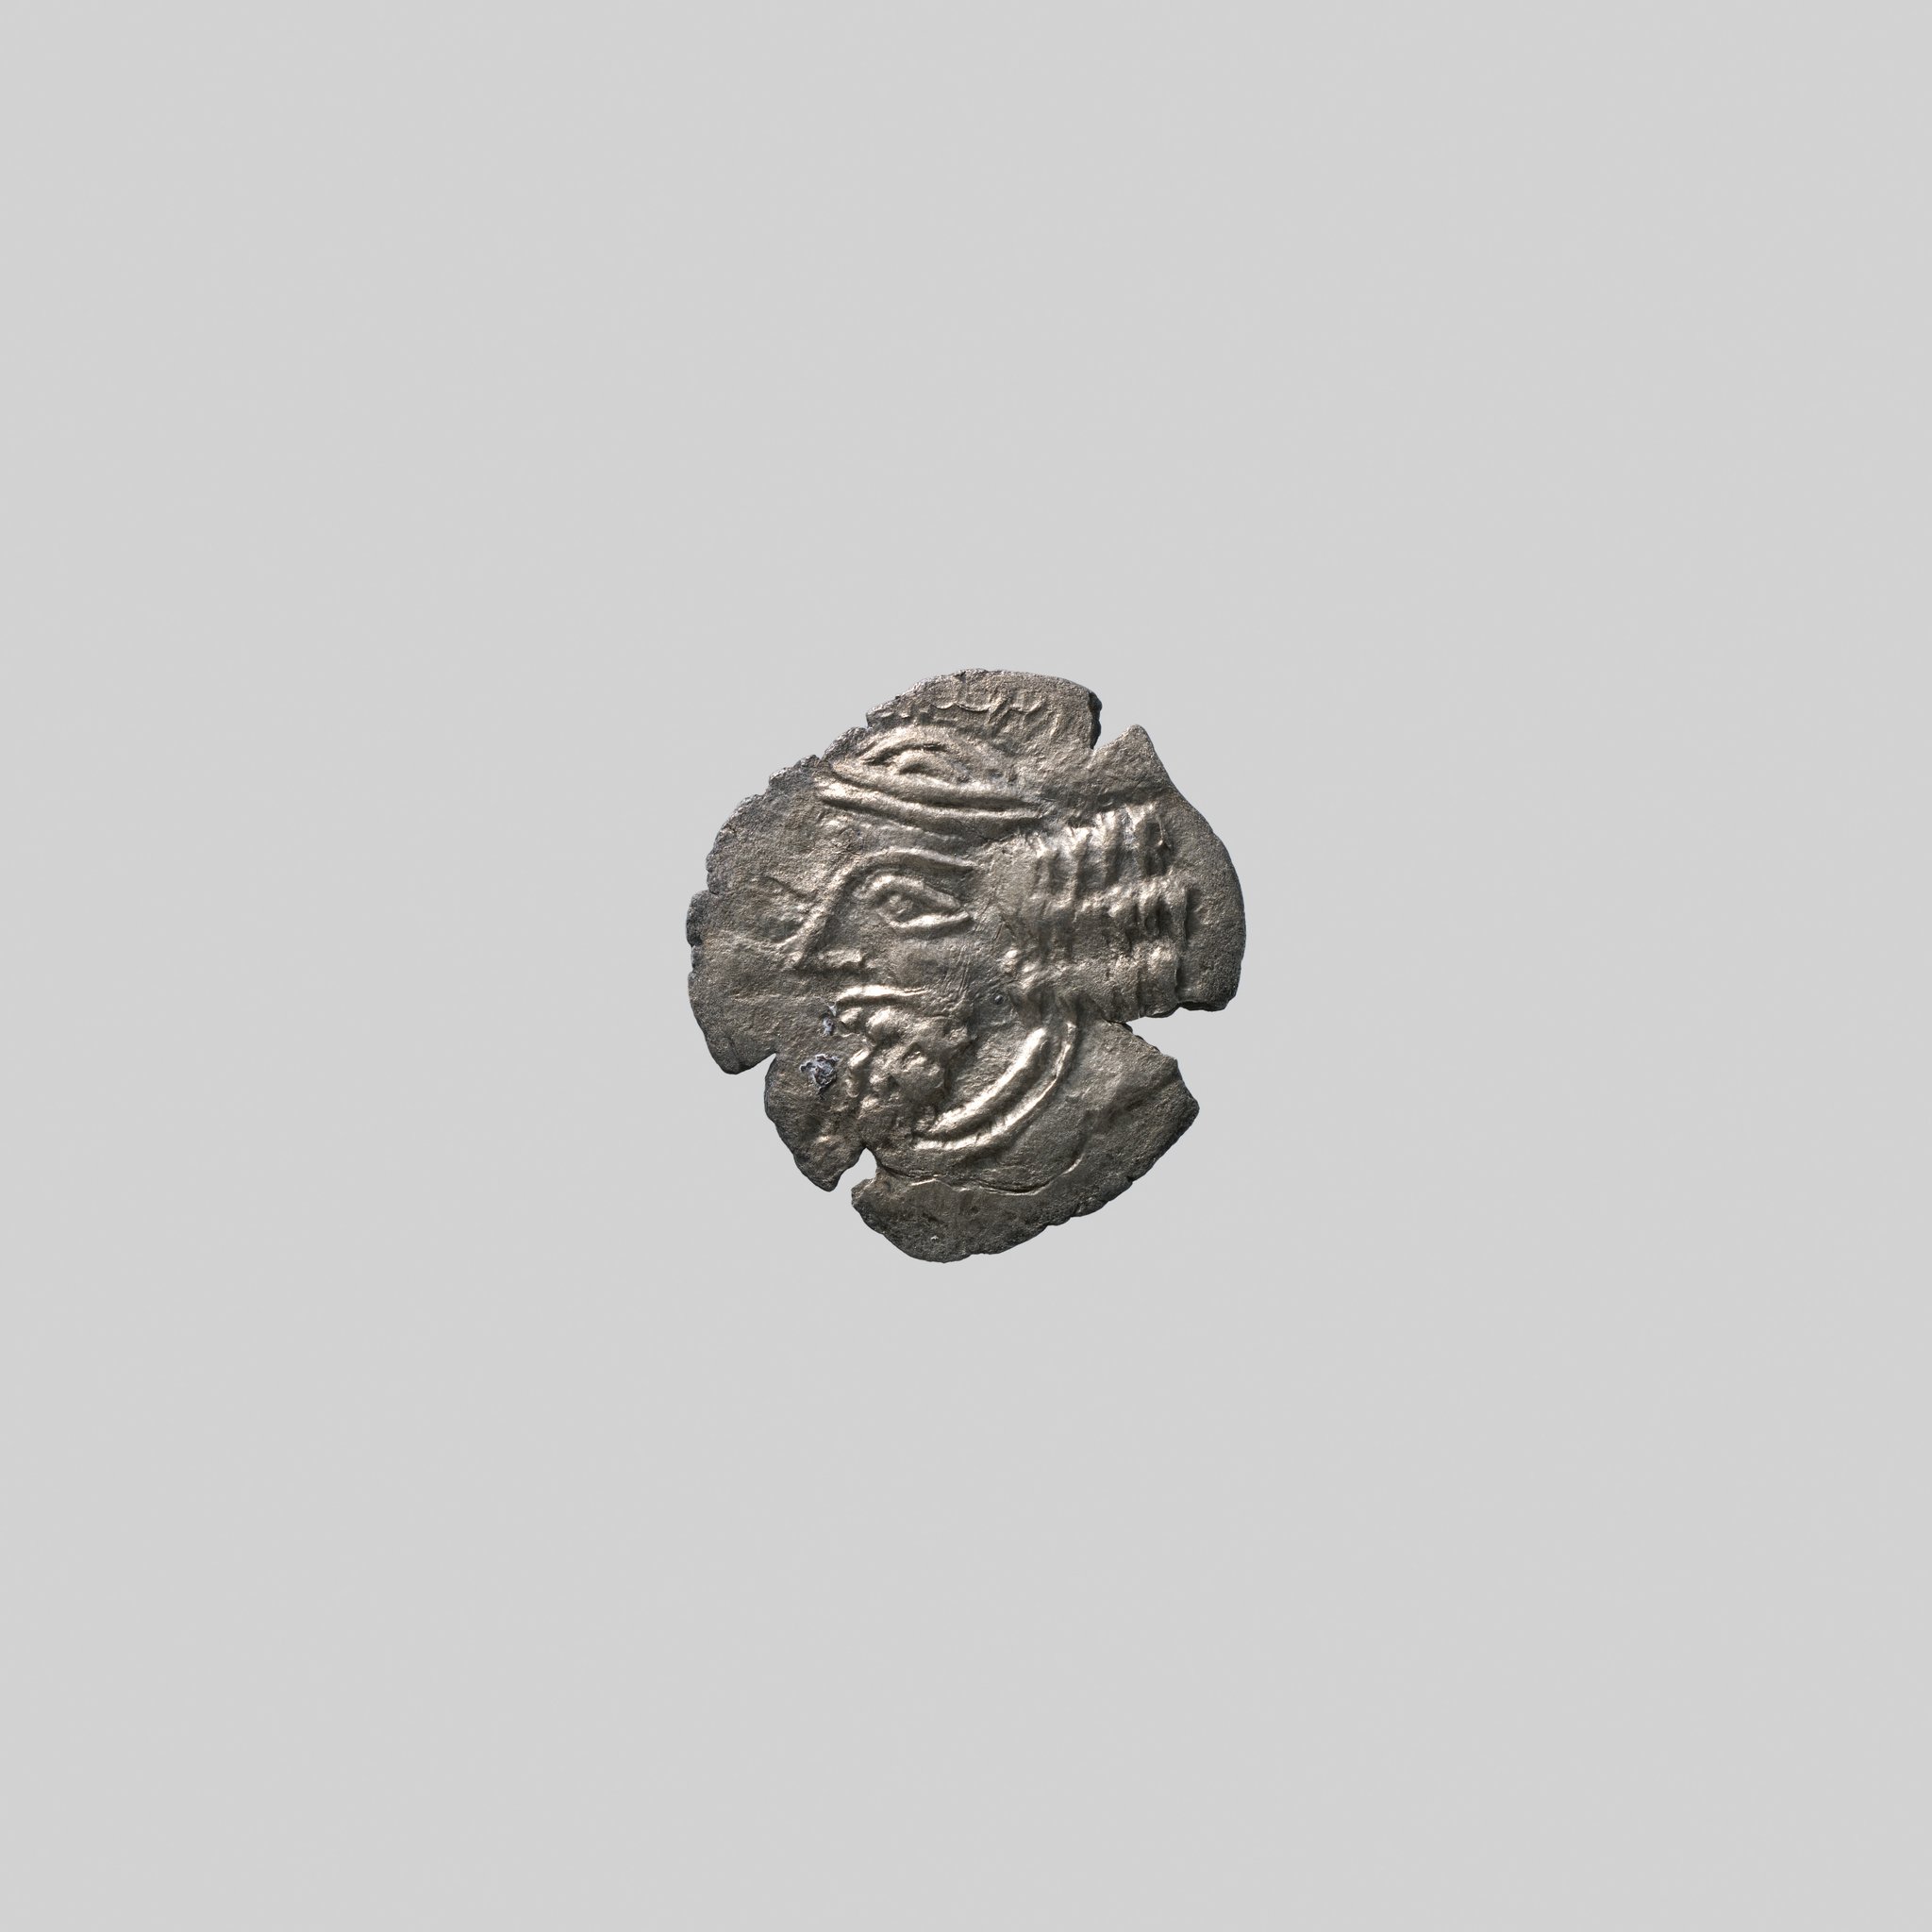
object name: coin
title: Hemidrachm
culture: parthian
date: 1-100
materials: silver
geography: iran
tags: profiles